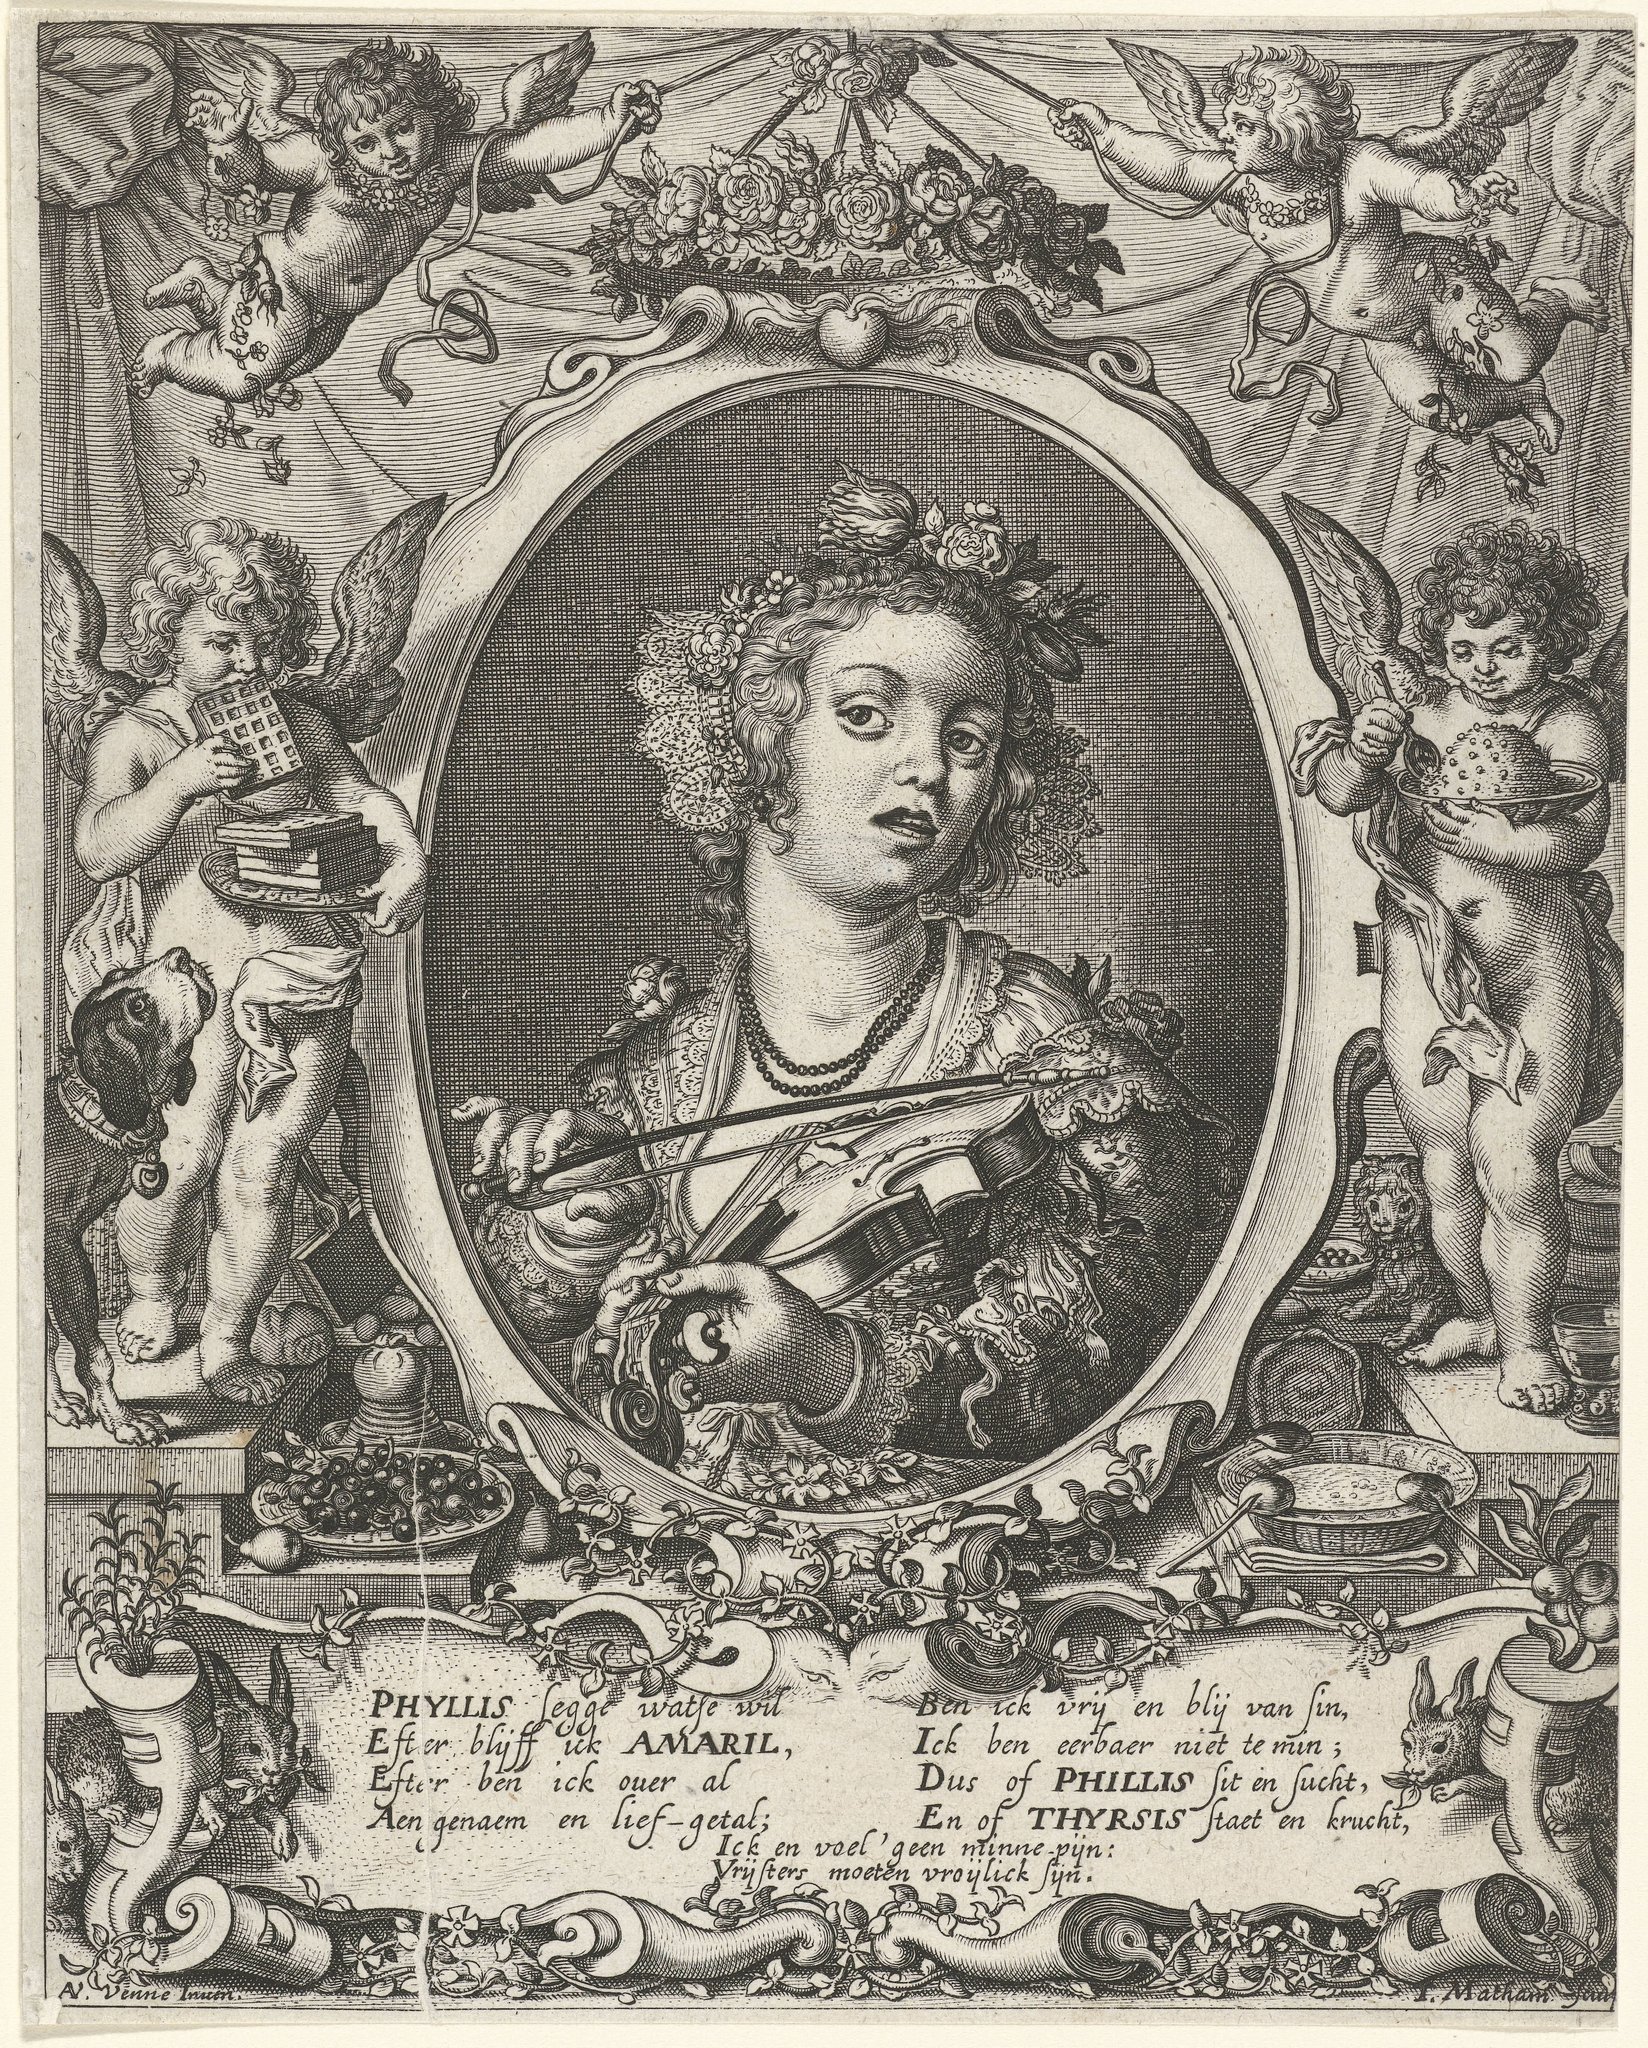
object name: print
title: Vioolspelend meisje in ornamentele omlijsting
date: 1615-1676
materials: paper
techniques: engraving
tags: sweets, dainties, adolescent, young woman, maiden, one person playing string instrument (bowed), violin, fiddle, spoon, waffles, cupids: 'amores', 'amoretti', 'putti'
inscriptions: collector's mark: Lugt 2228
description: Vioolspelend meisje in een ovaal cartouche. Links staat een putto die wafels eet, met aan de voeten een hond. Achter de putto is een wafelijzer zichtbaar. Rechts een putto met een kleine hond, die met een lepel uit een schaal met een lekkernij eet. Bovenaan eveneens twee putti met bloemen. Op de voorgrond een schaal met vruchten en een bord met drie lepels. Het onderschrift identificeert de vioolspeelster als de verleidelijke Phyllis.